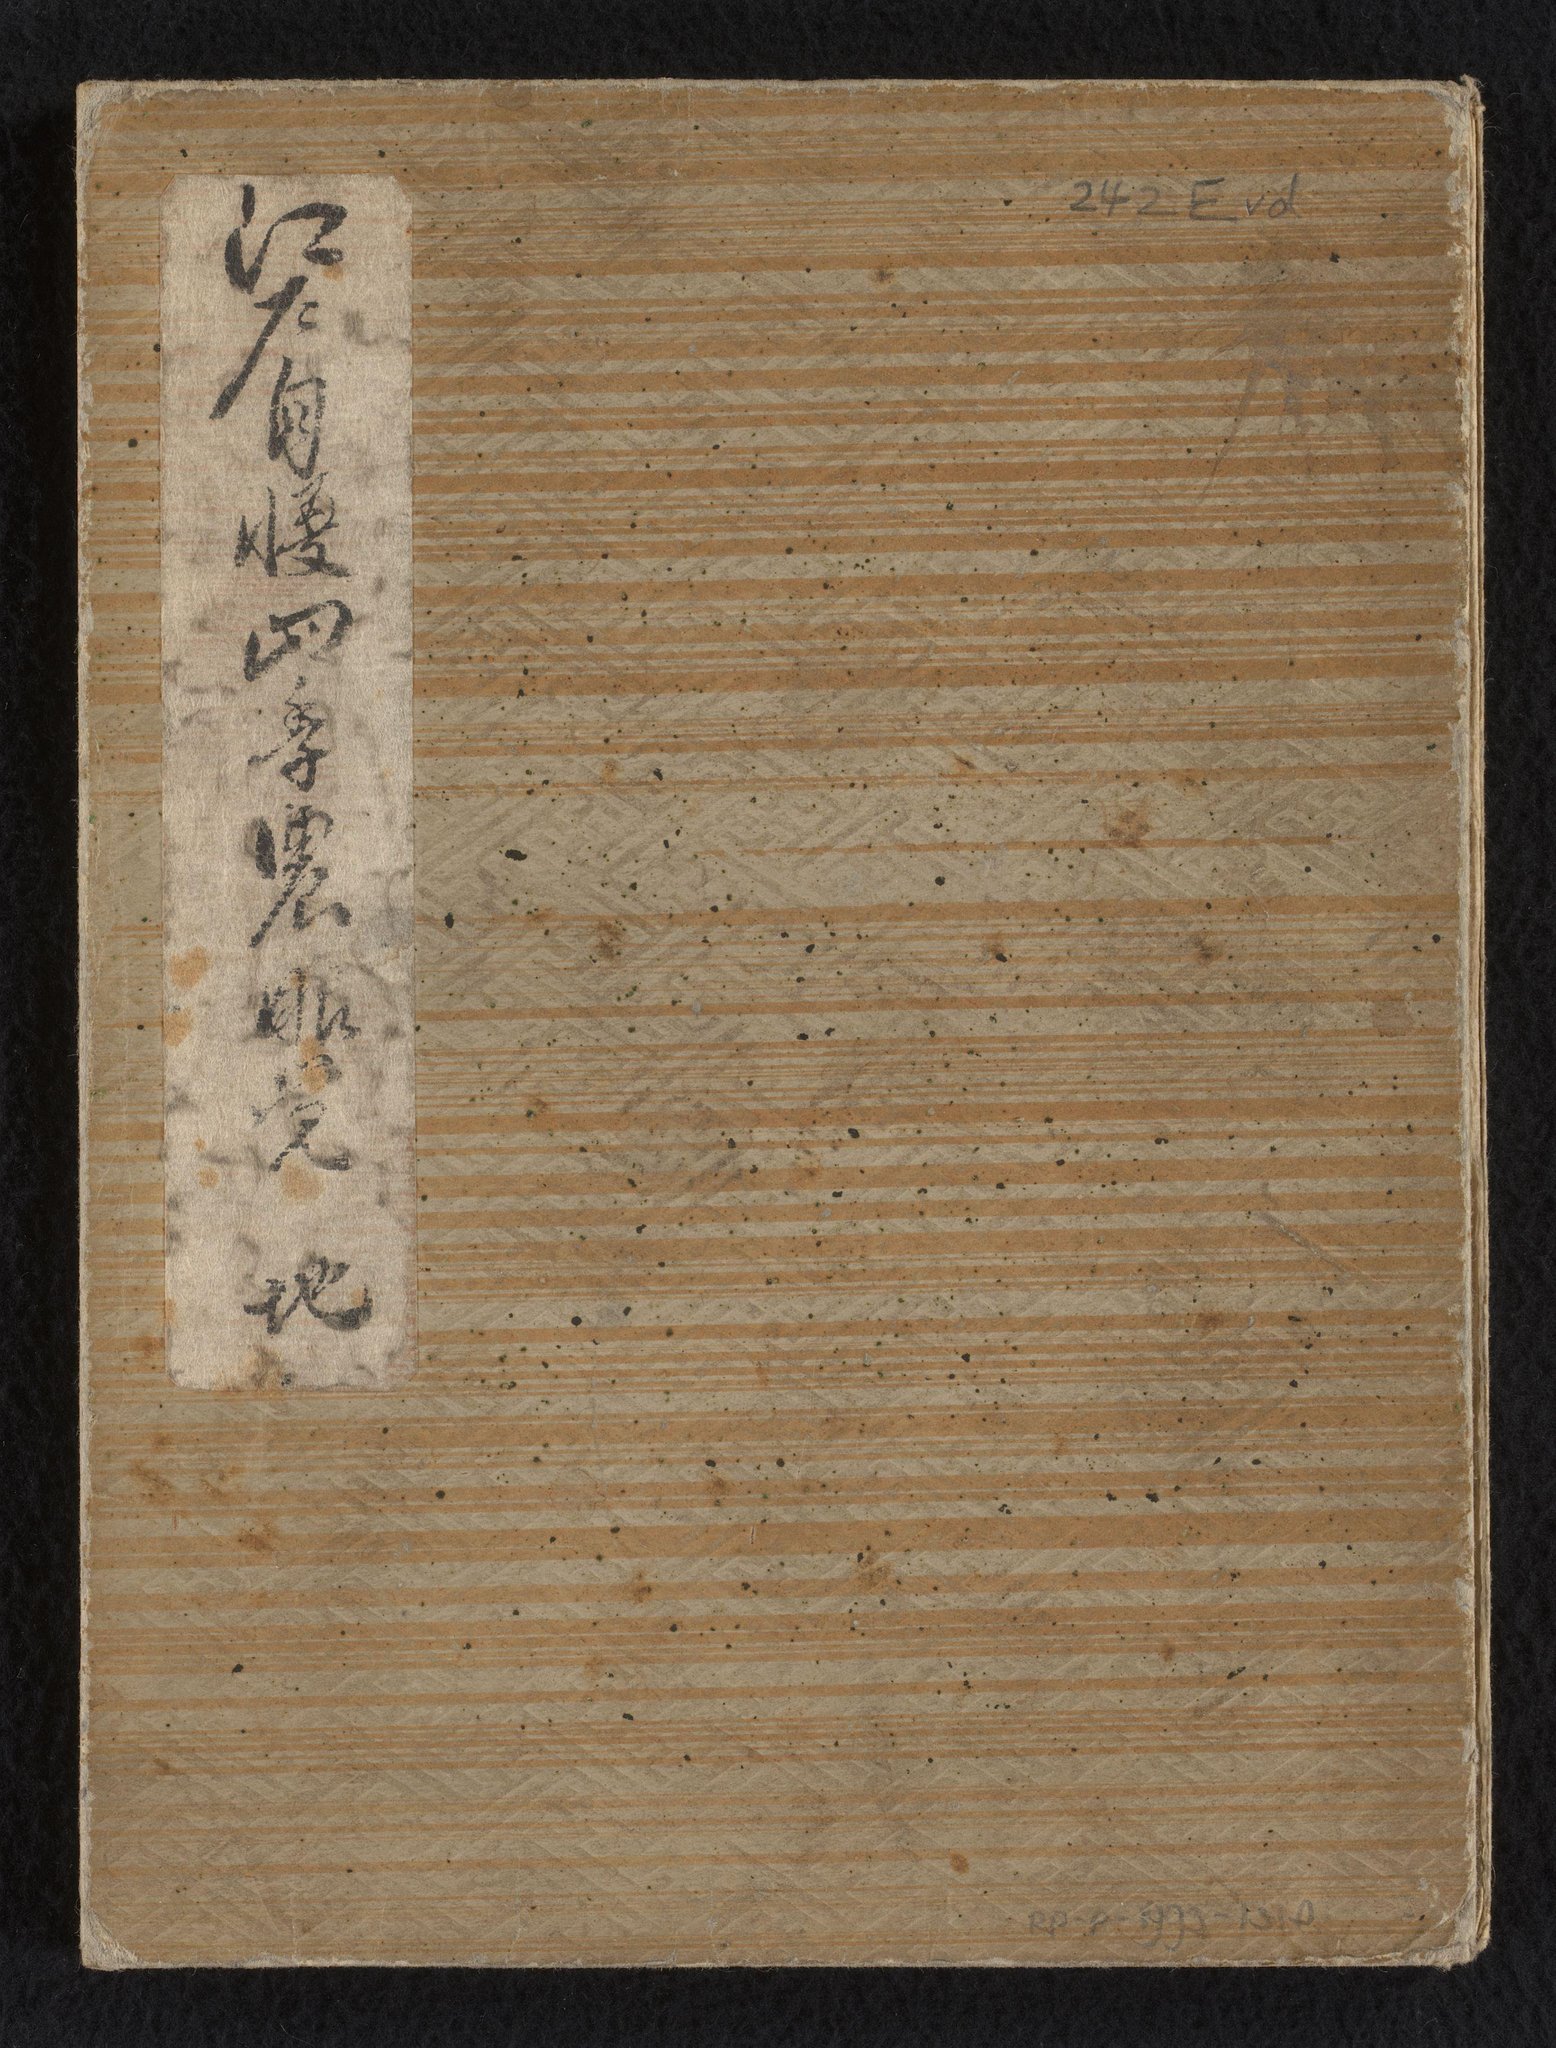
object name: prentrecueil, prentenalbum, prentalbum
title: Album met Japanse prenten - linker deel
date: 1853-1856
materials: paper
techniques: woodcut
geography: japan